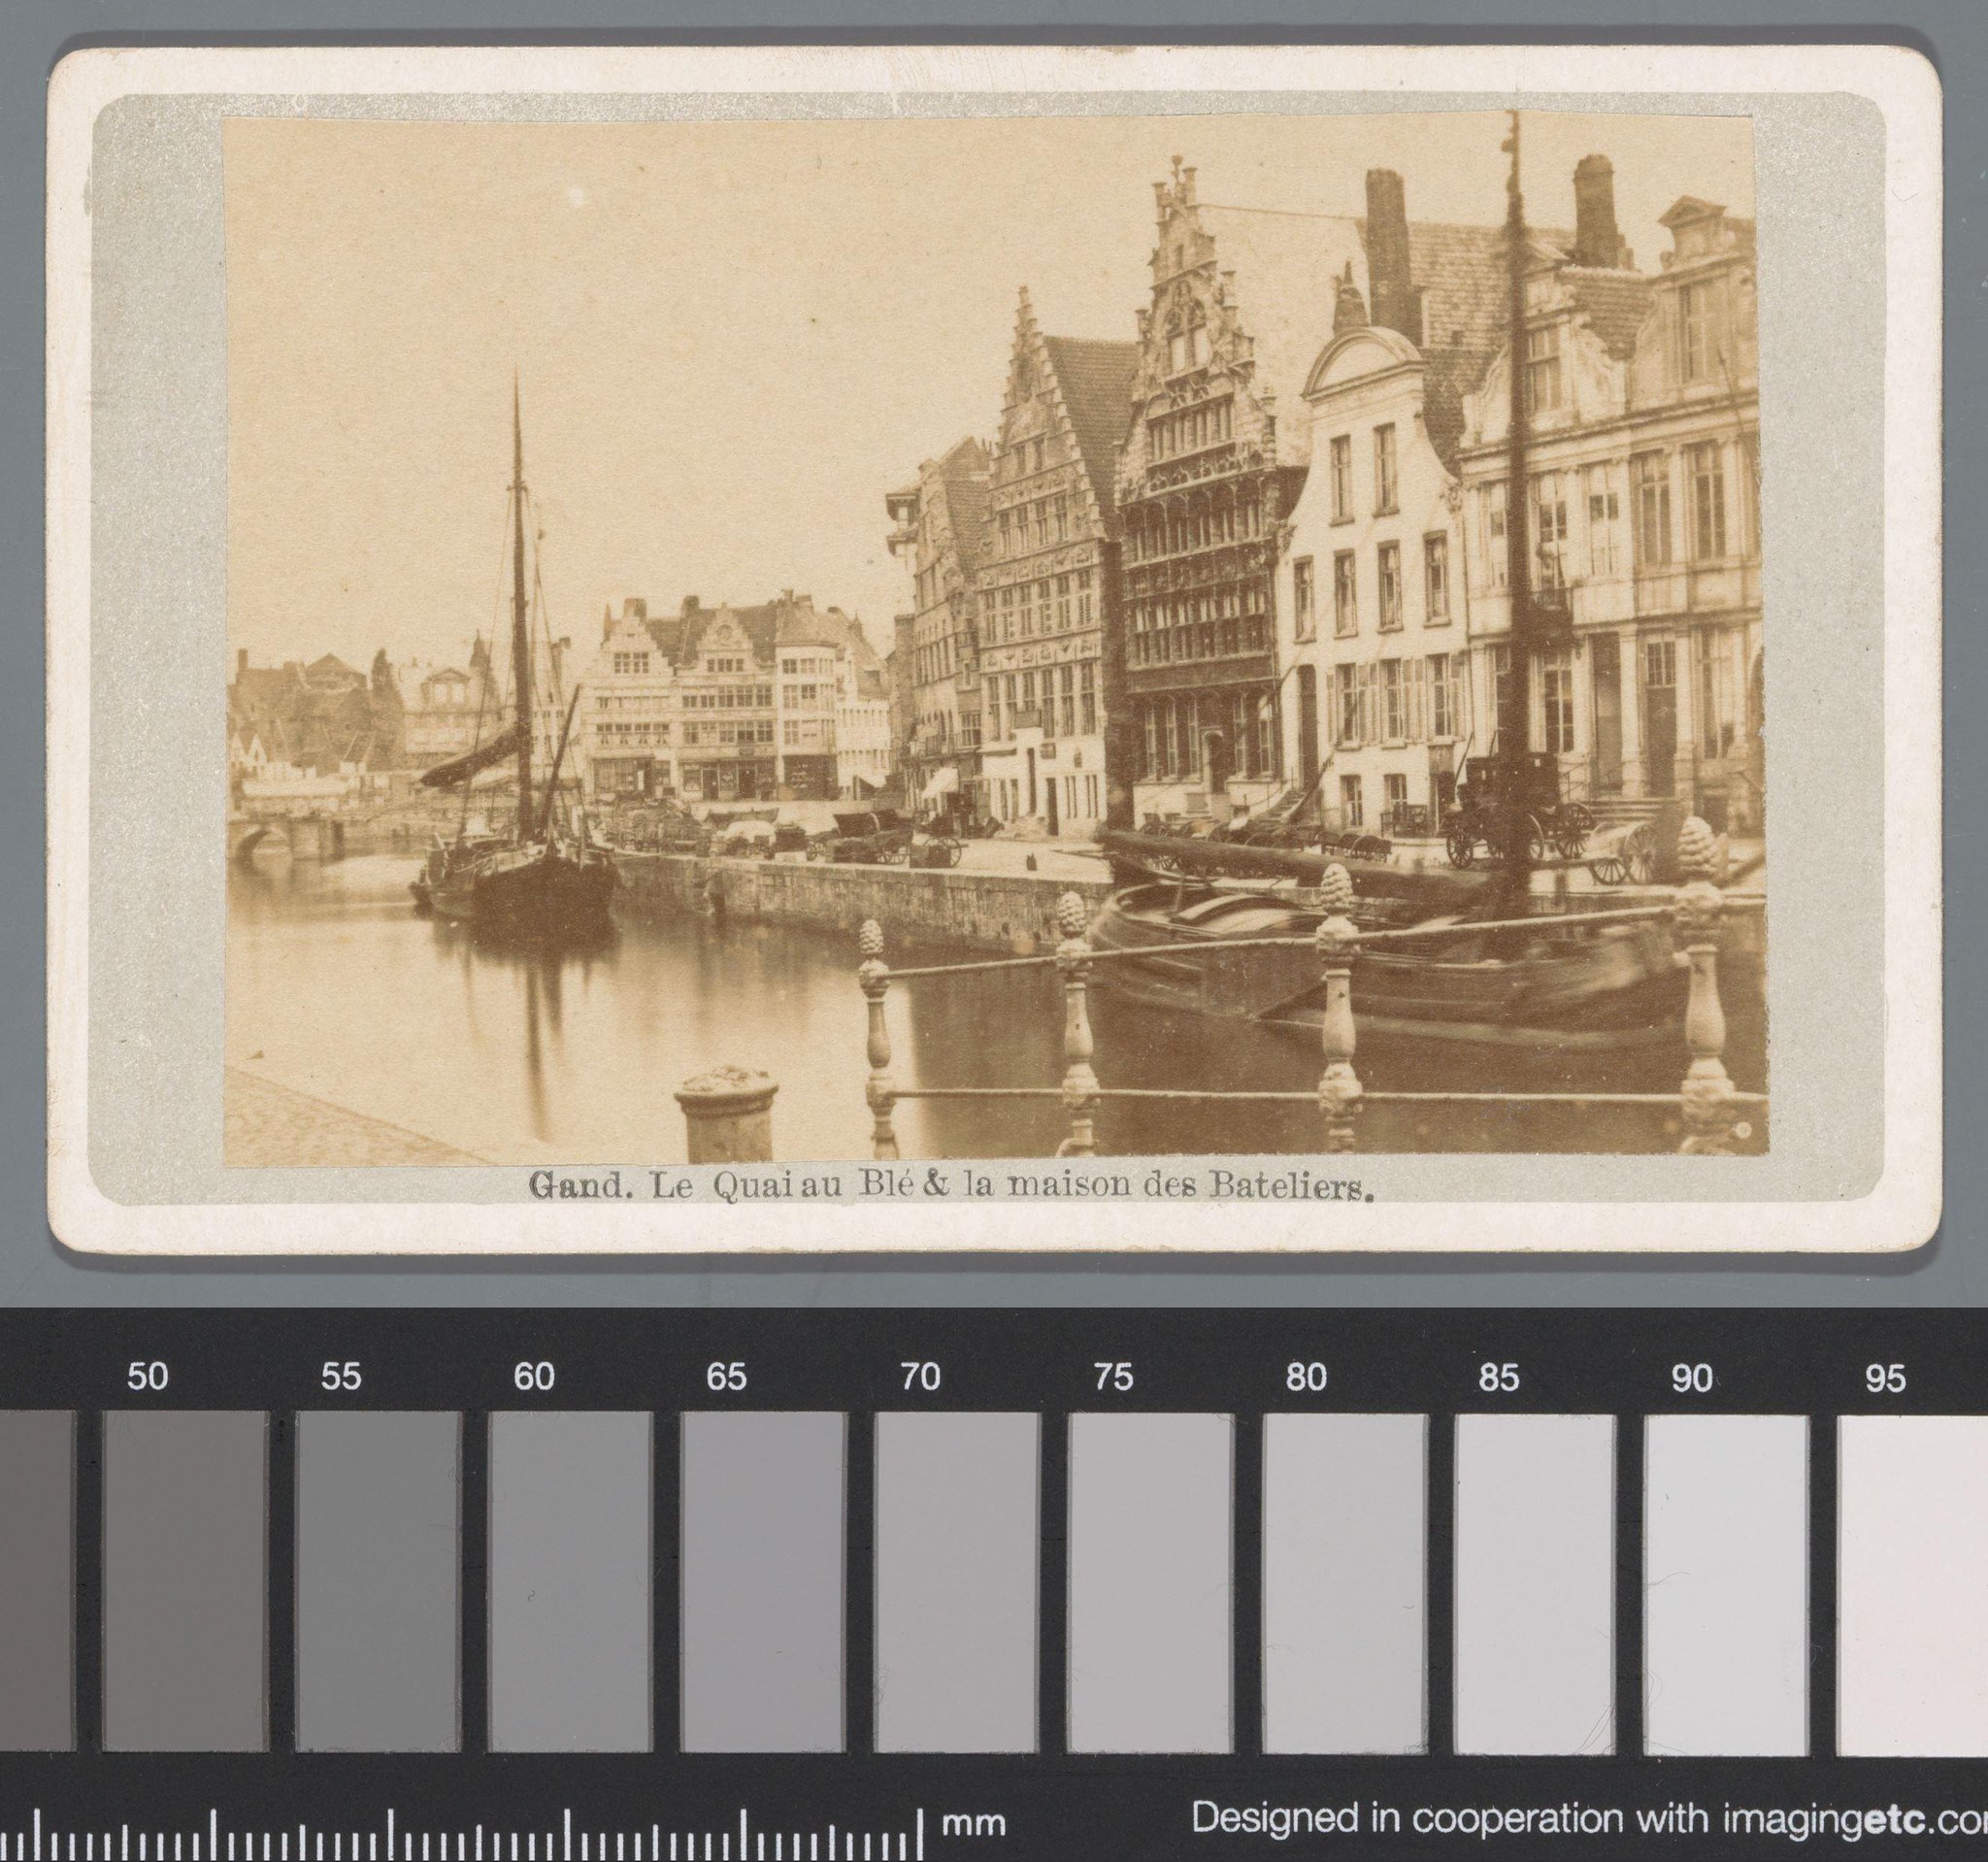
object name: carte de visite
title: Graslei en het gildehuis der Vrije Schippers, Gent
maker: Anonymous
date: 1855-1885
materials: cardboard, paper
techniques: albumen print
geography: ghent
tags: guildhall, canals, waters (in city), ghent